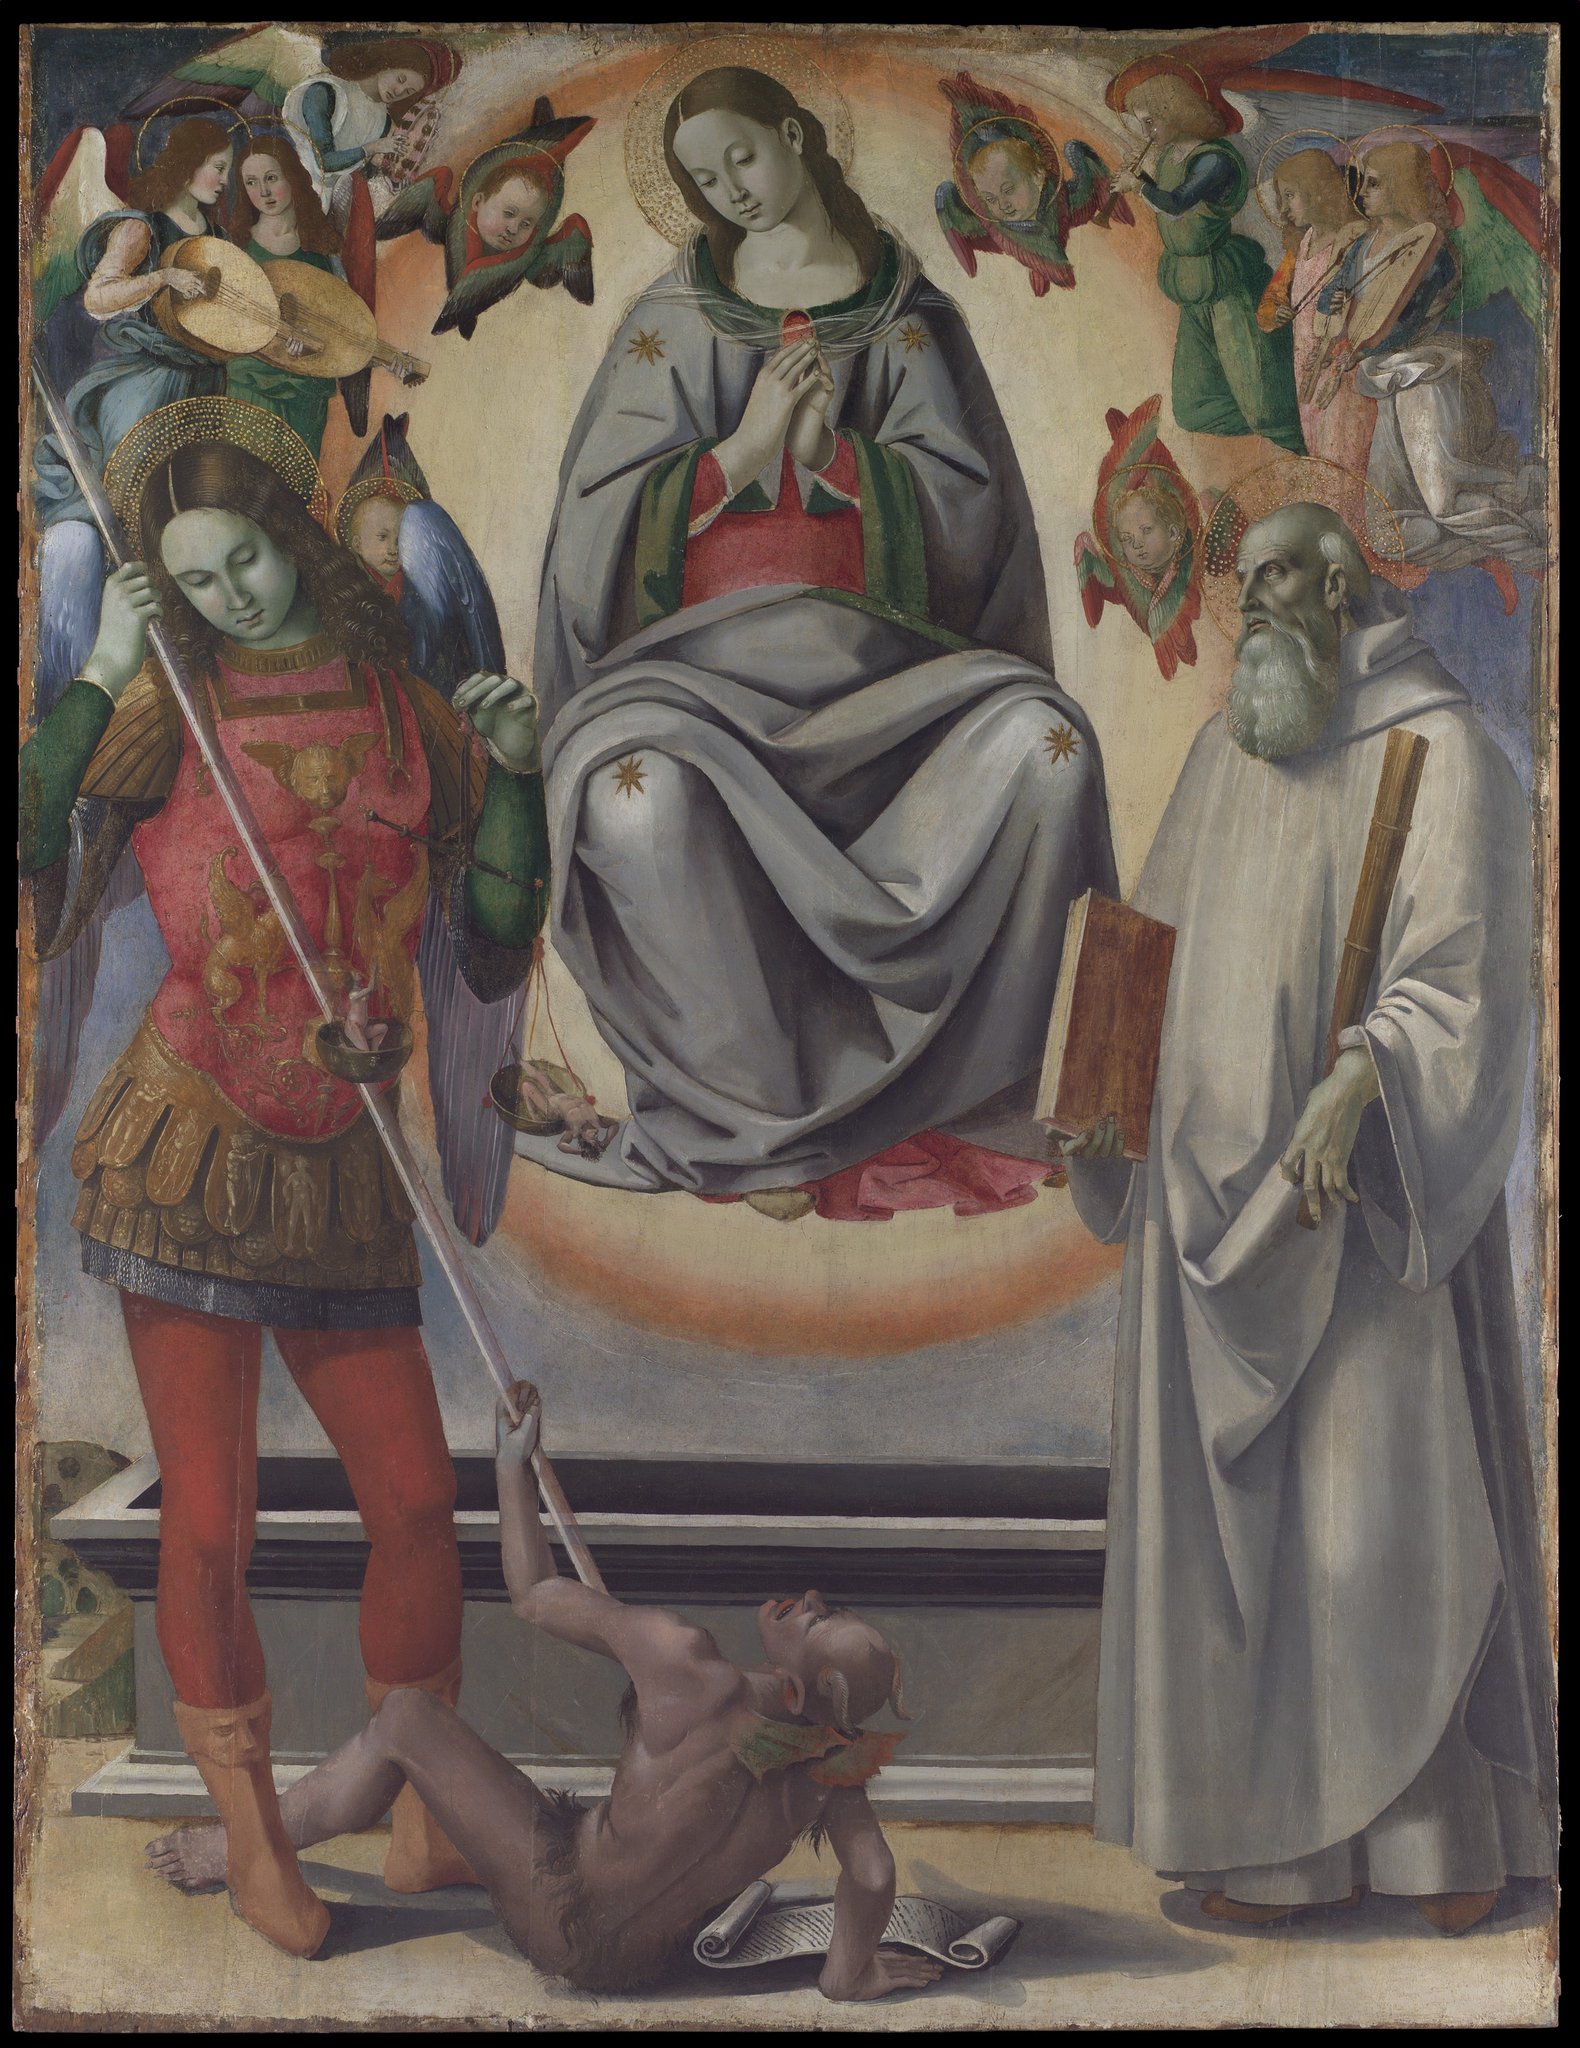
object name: painting, altarpiece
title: The Assumption of the Virgin with Saints Michael and Benedict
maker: luca signorelli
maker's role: artist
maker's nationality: italian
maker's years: 1470-1523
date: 1493-1496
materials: gold, oil, wood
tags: angels,saint michael,virgin mary,devil,assumption of the virgin,saints